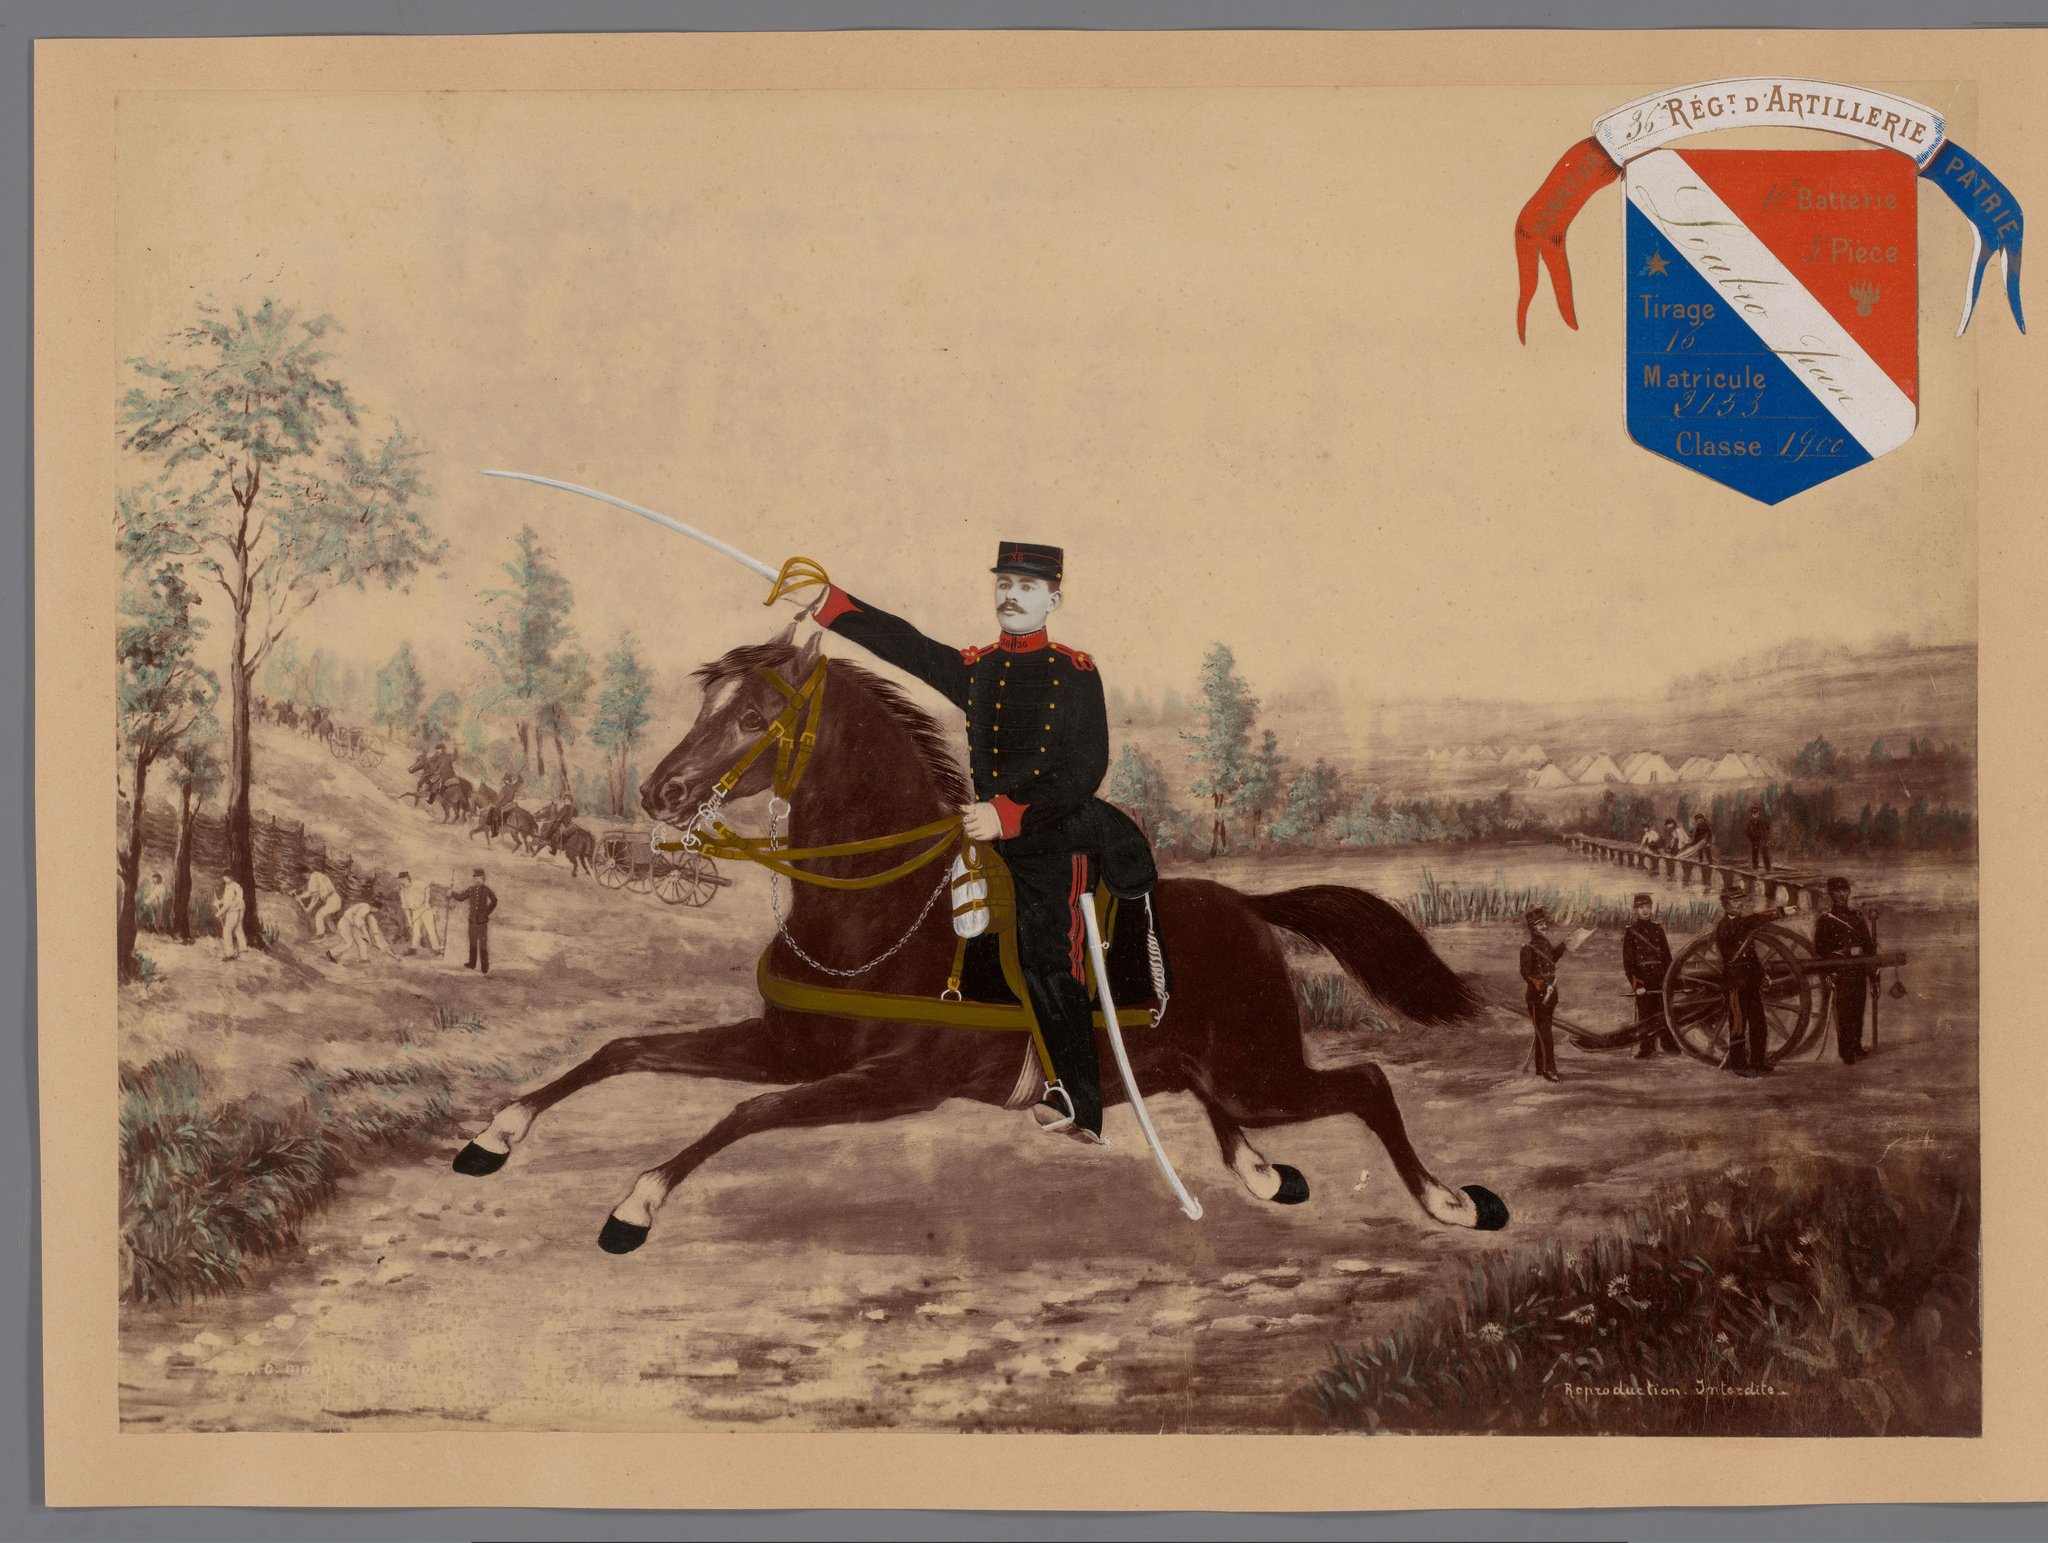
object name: photograph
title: Portret van een Franse militair (cavalerist) te paard, Jean Labro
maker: Anonymous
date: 1900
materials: ink, paper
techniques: gelatin silver print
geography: france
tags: riding a horse, ass, or mule; rider, horseman, the soldier; the soldier's life (+ cavalry, horsemen)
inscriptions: inscription: ‘Rechtsboven: “HONNEUR / [in pen ingevuld: 36e] RÉGT D’ARTILLERIE / PATRIE / [in pen ingevuld: 1oe] Batterie / [in pen ingevuld: 3e] Pièce / [in pen ingevuld: Labro Jean] / Tirage [in pen ingevuld: 16] / Matricule [in pen ingevuld: 2153] / Classe [in pen ingevuld: 1900]’ Rechtsonder, meegedrukt: ‘Reproduction Interdite’. Linksonder meegedrukt: ‘[onleesbaar] déposé’’